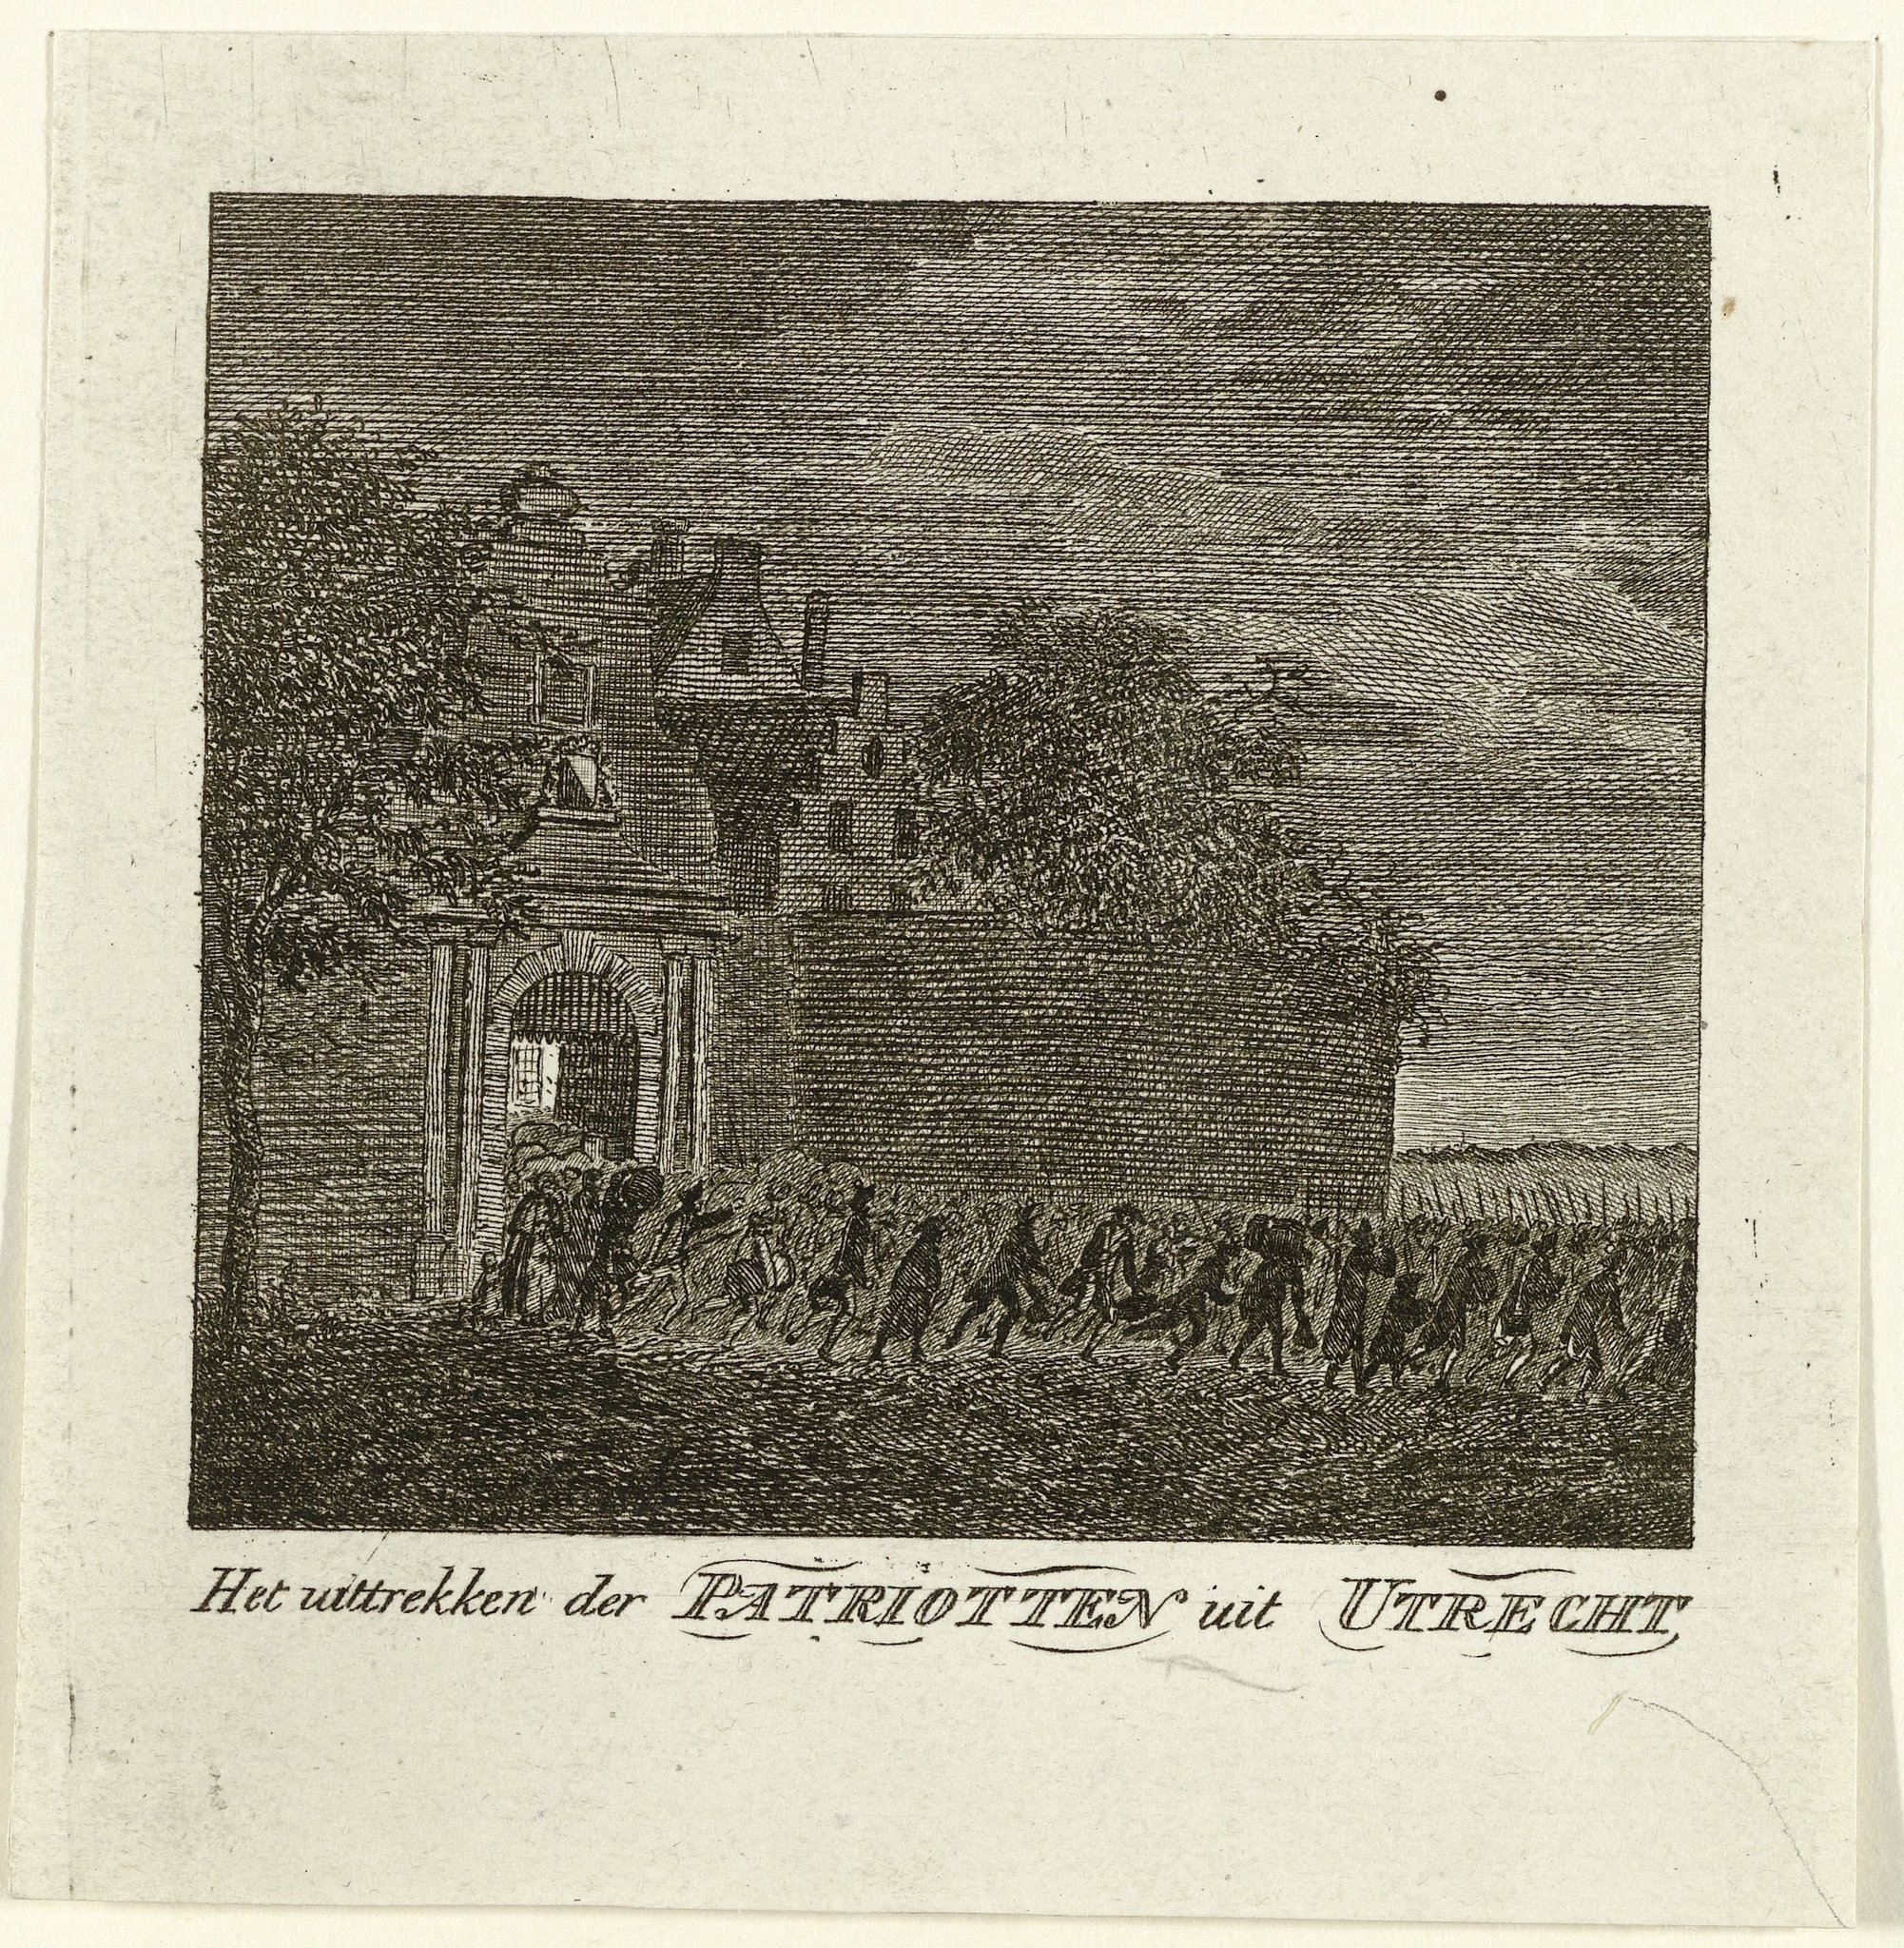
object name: print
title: Patriotten verlaten Utrecht, 1787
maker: Anonymous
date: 1787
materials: paper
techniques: etching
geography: northern netherlands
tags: putting the enemy to flight - hh - being put to flight, fleeing (+ citizen soldiery, civil guard, citizen militia), utrecht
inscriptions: collector's mark: Lugt 2228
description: Uittocht van patriotten uit Utrecht in de nacht van 15 op 16 september 1787, bij het naderen van de Pruisische troepen.